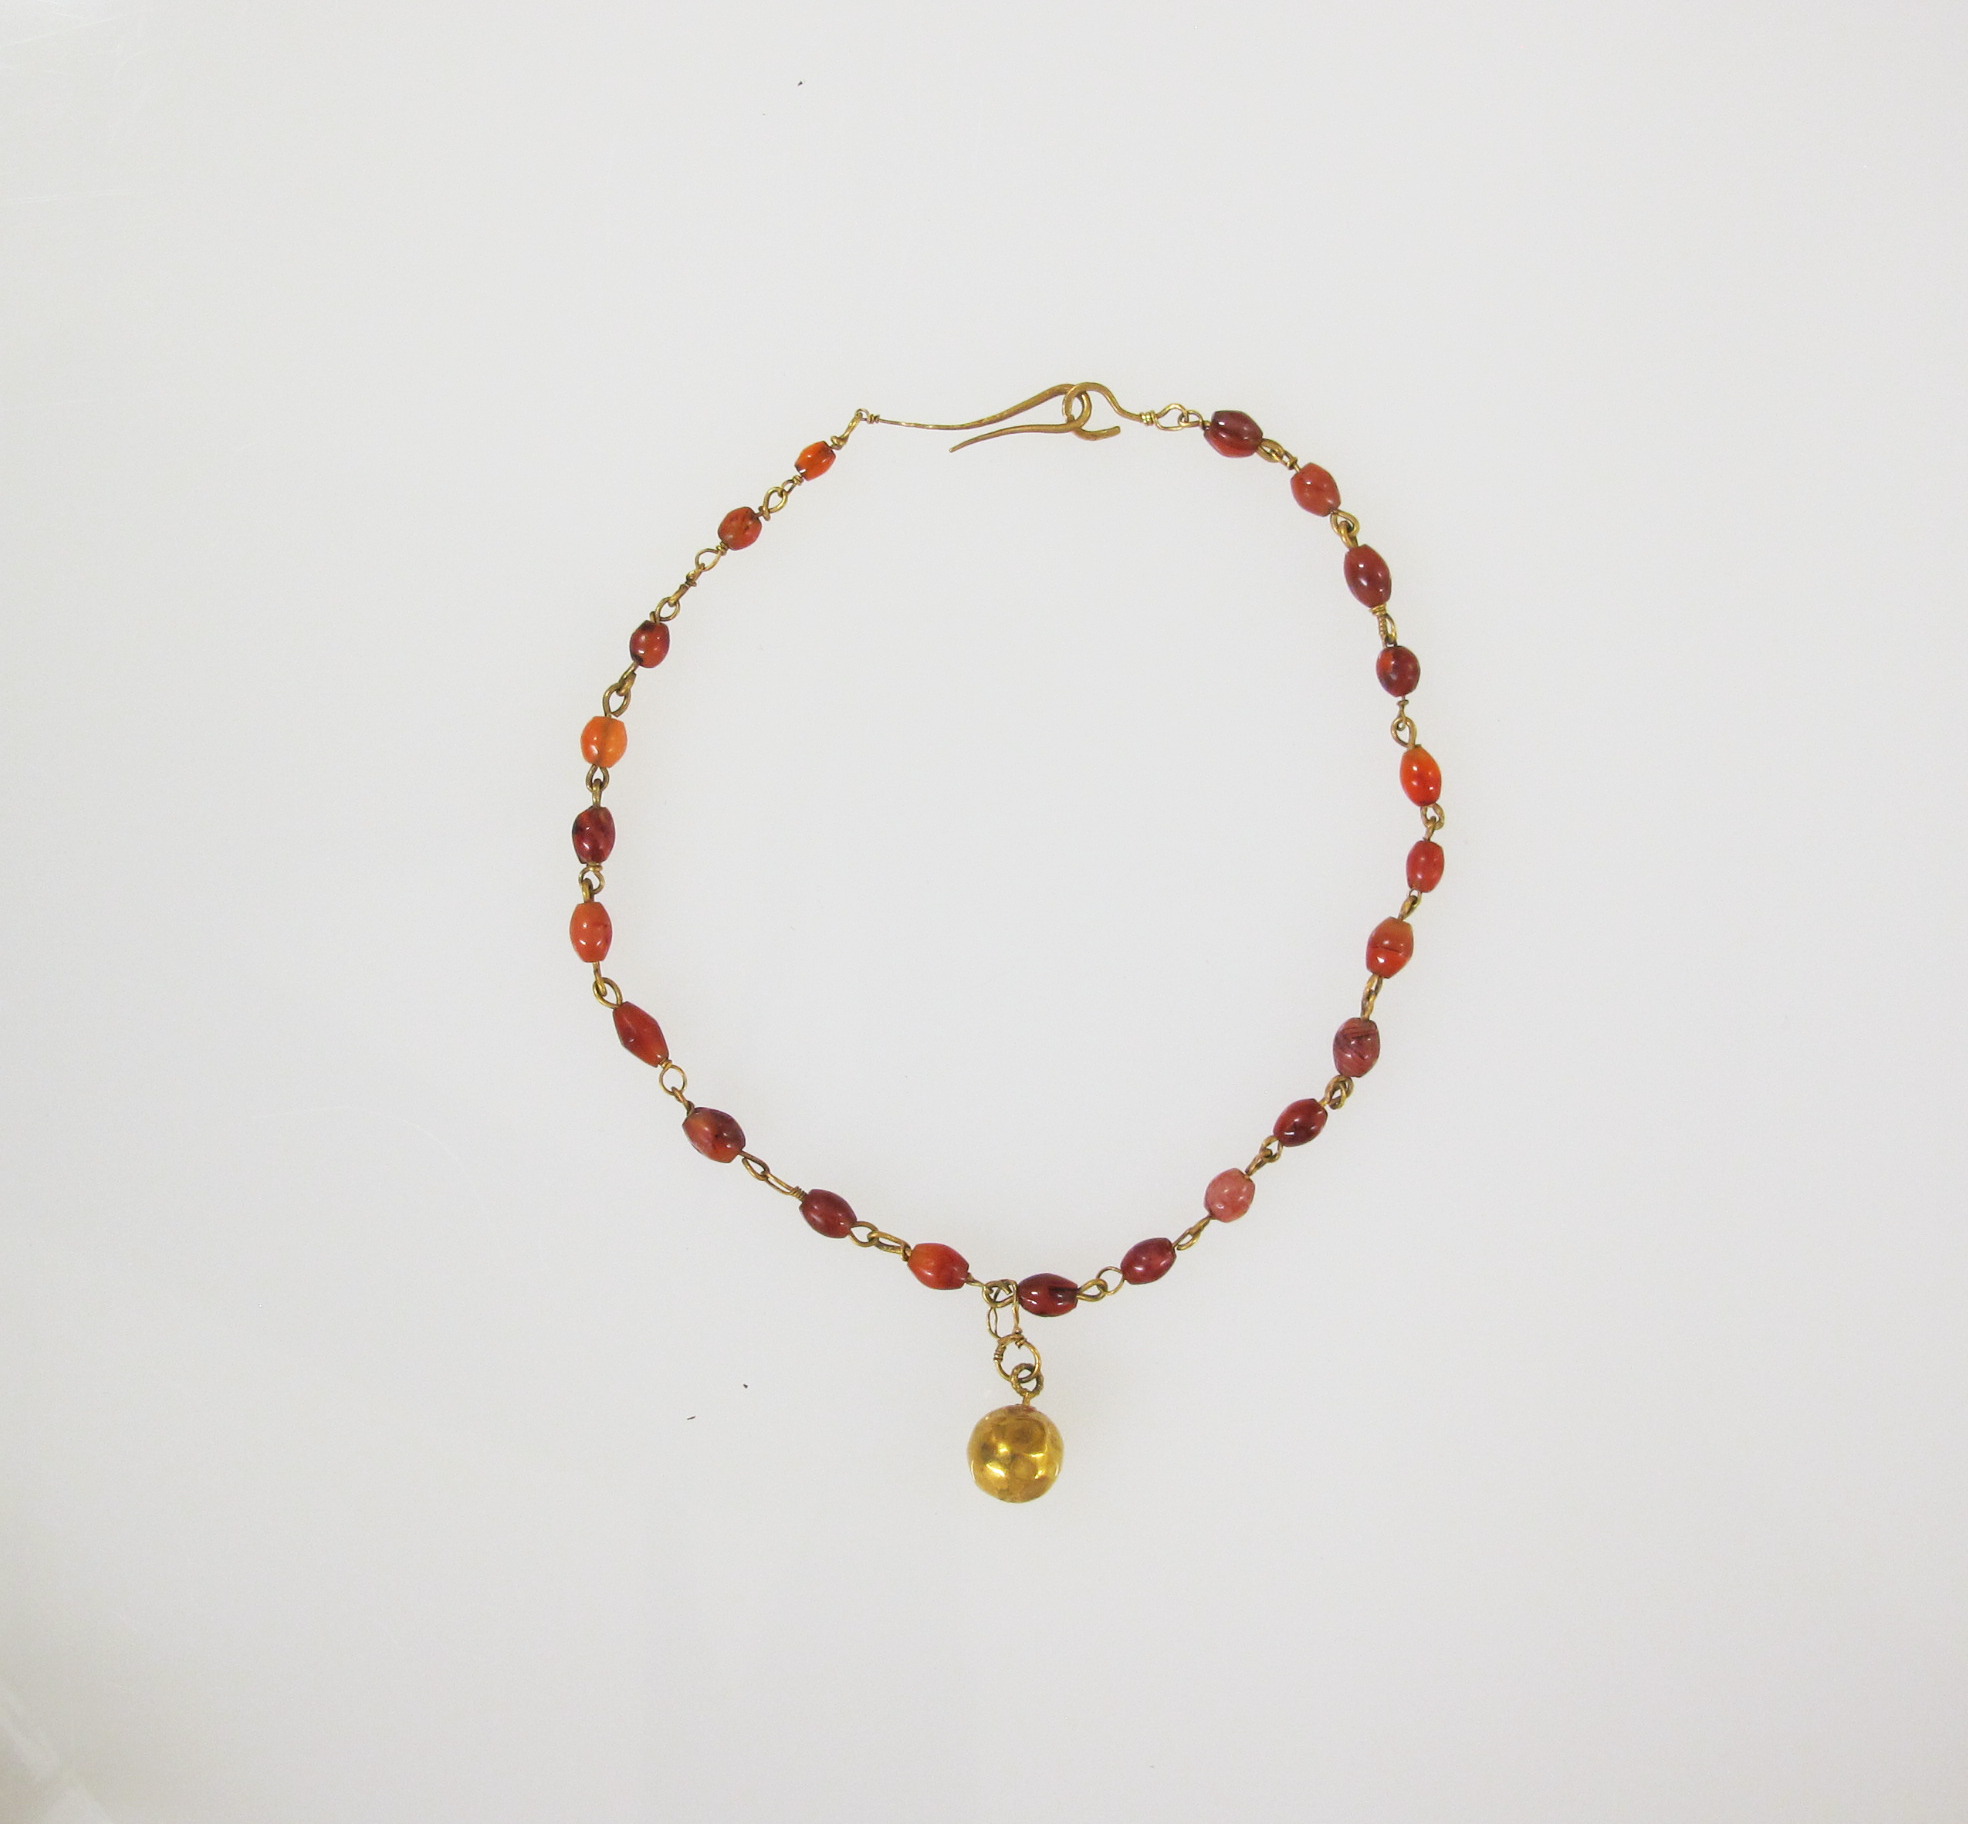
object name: necklace with carnelian bead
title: Necklace with carnelian beads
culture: roman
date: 100 BCE-100 CE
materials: gemstone, gold